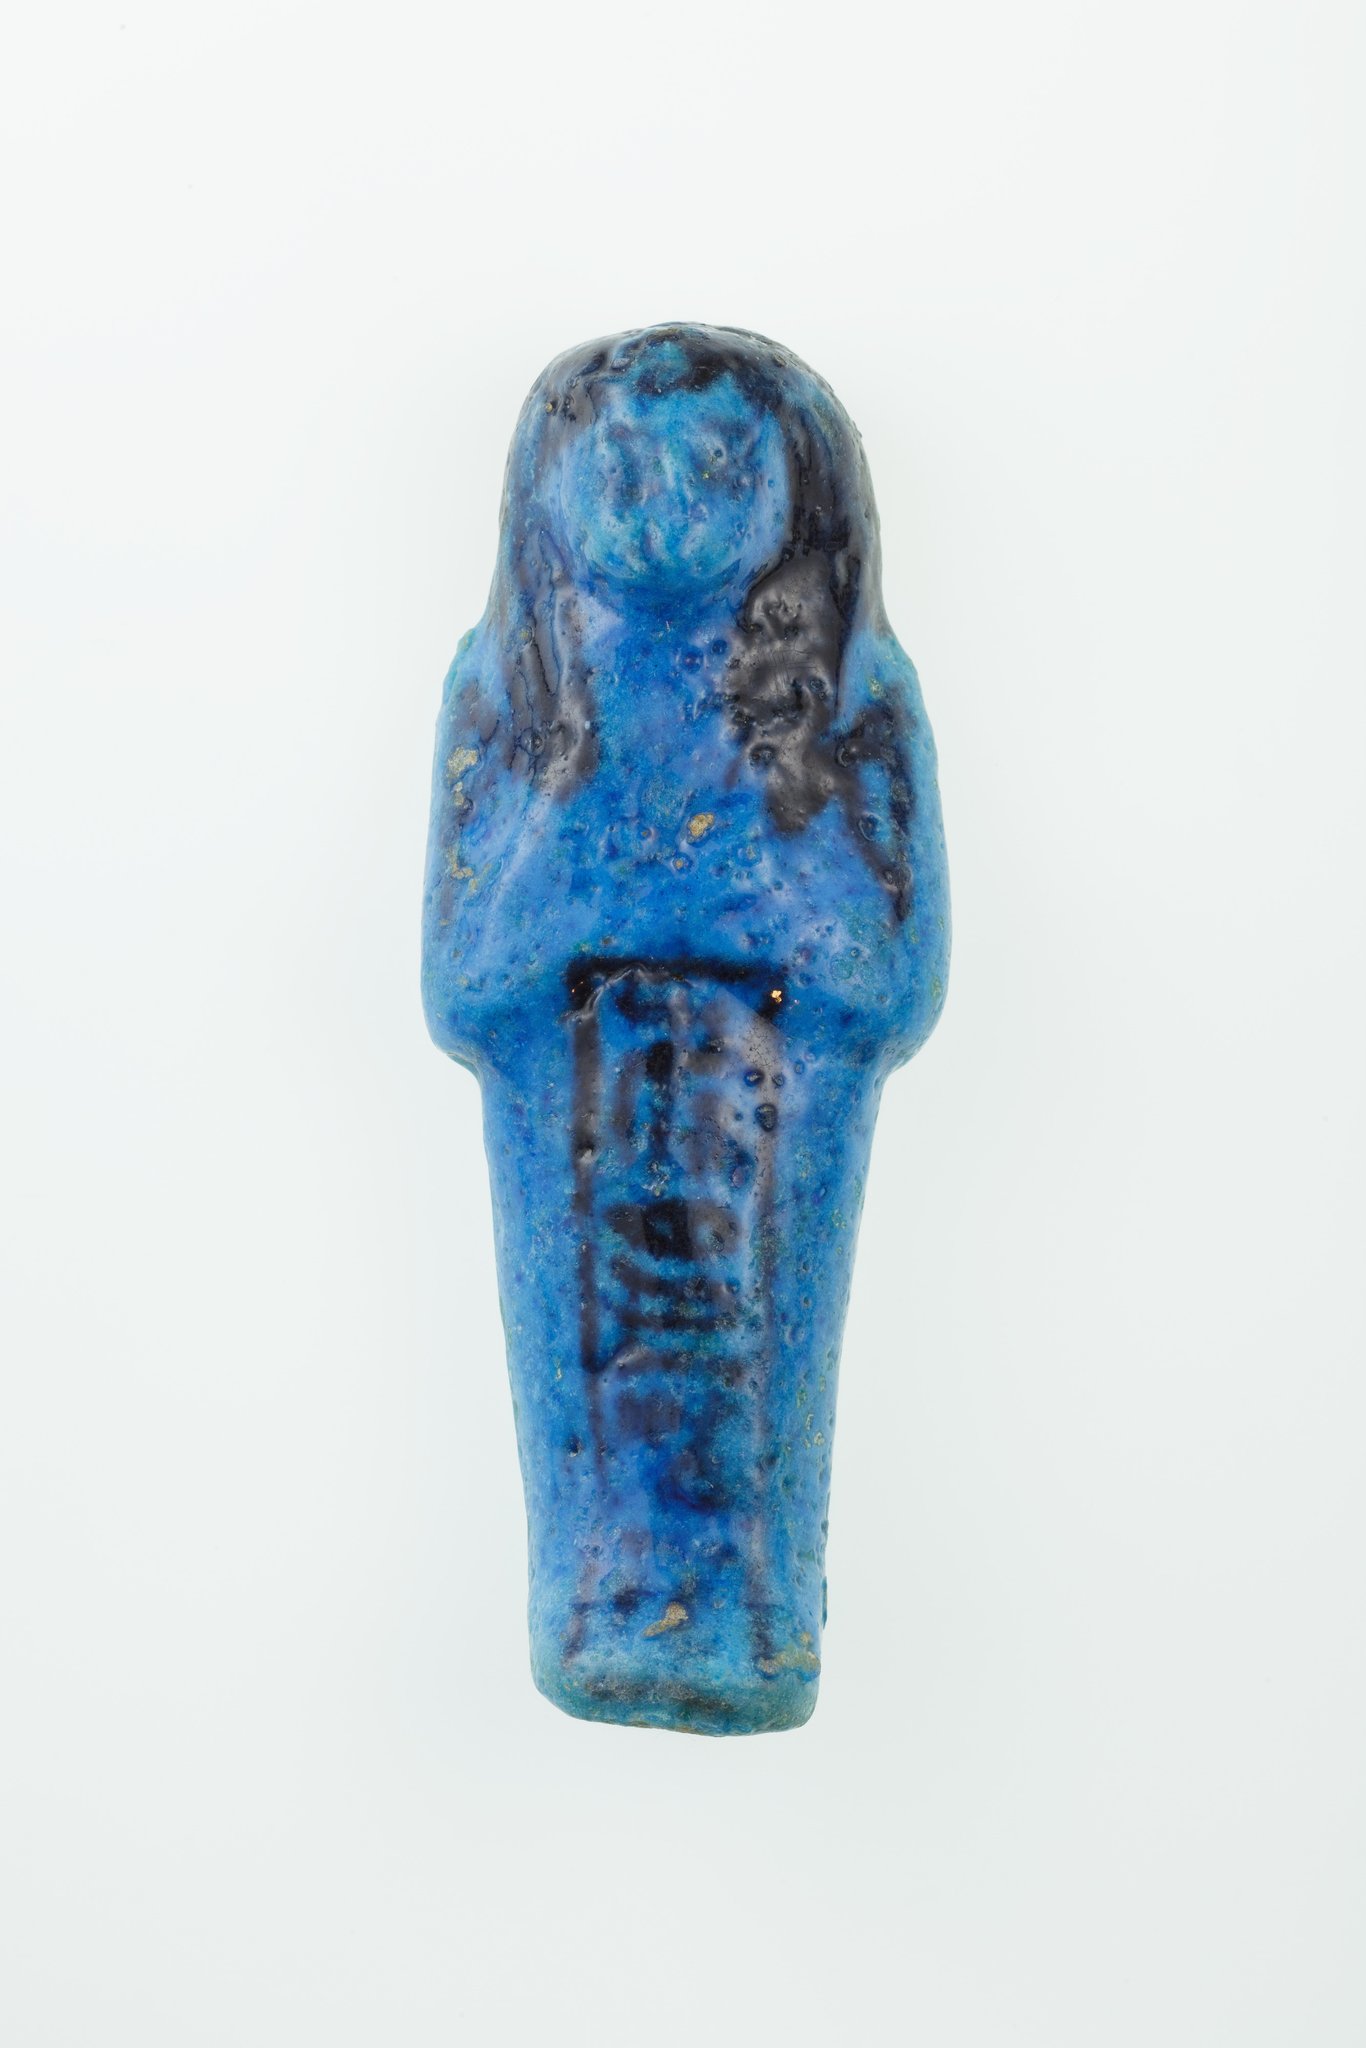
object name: shabti, worker, nauny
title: Worker Shabti of Nauny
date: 1050 BCE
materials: faience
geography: egypt